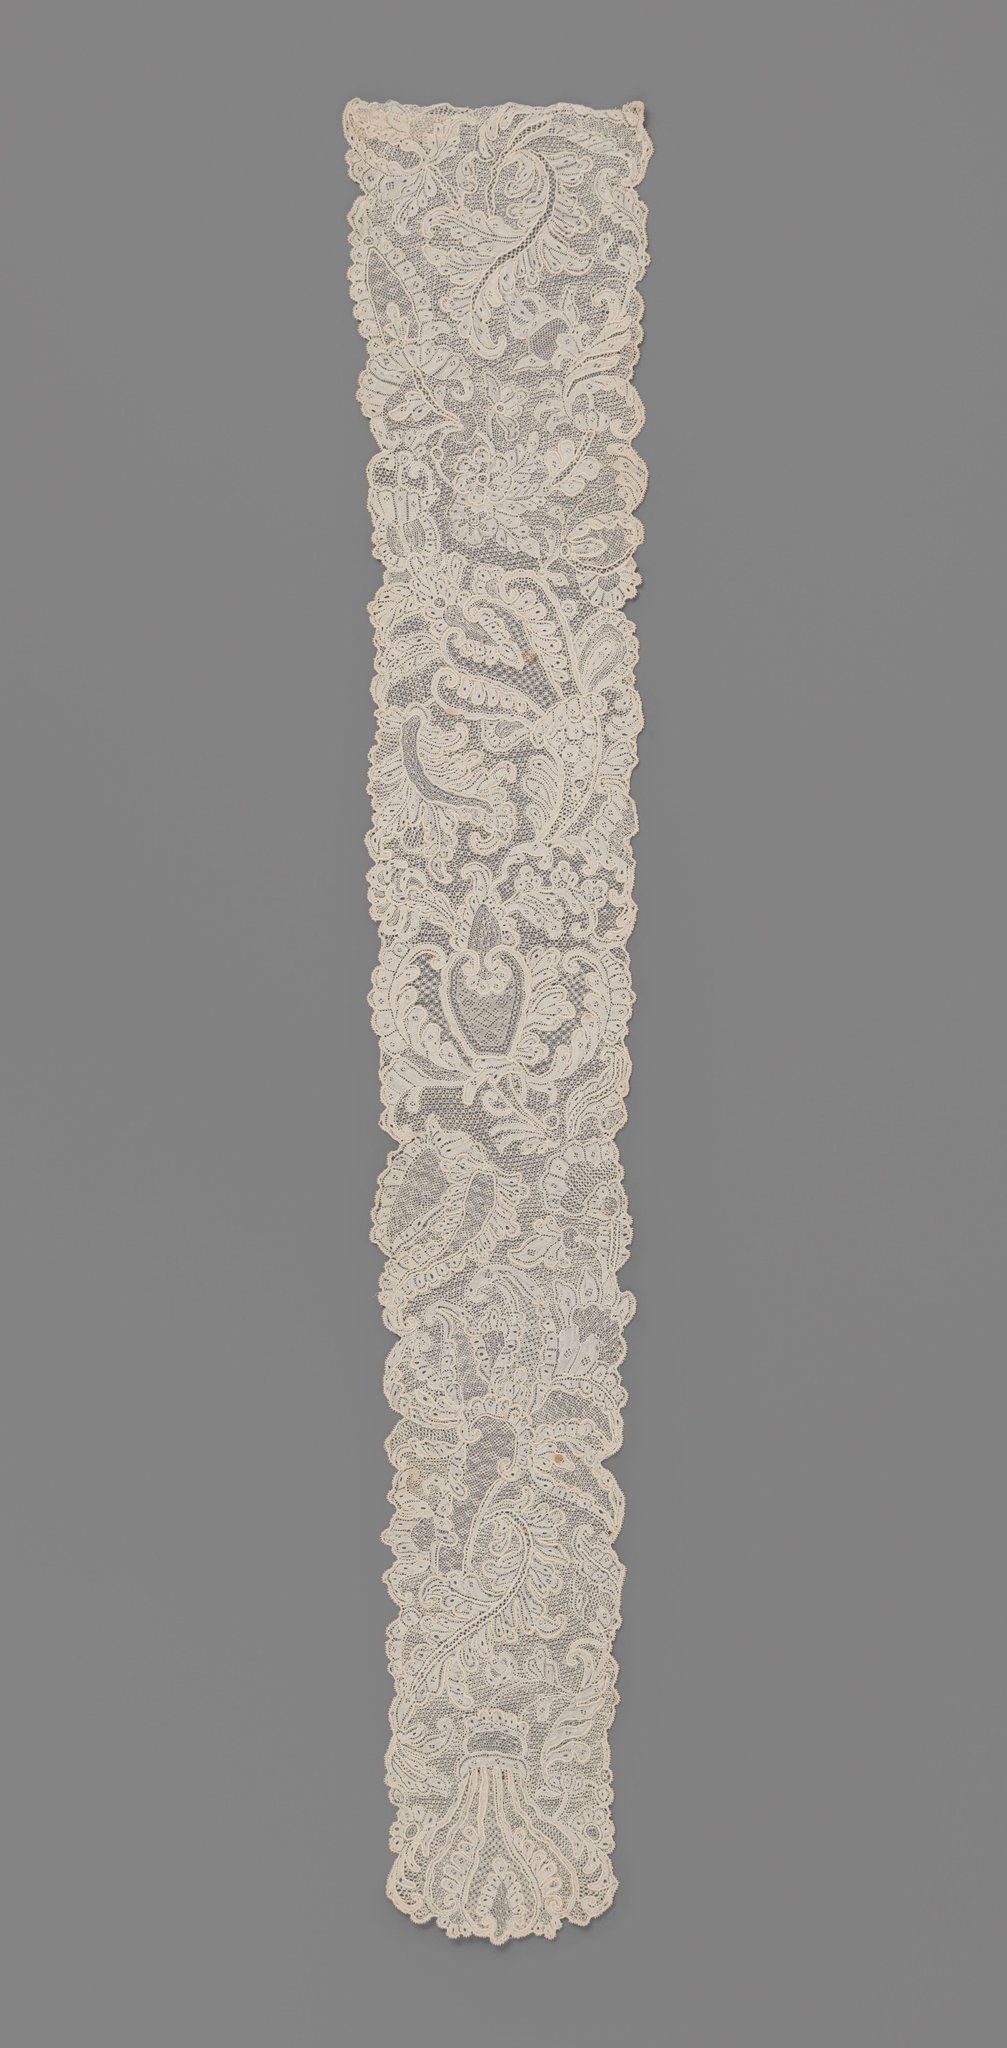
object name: womenswear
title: Mutsenslip van naaldkant met acanthusbladeren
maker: Anonymous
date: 1720-1730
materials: linen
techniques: needle lace, régence lace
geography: france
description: Mutsenslip van naturelkleurige naaldkant, Régence-kant. Patroon met acanthusbladeren en weelderige bloemen, op een maasgrond versierd met vierkante moesjes. Volwerk met uitsparingen en veelsoortige siersteken. Reliëfcontouren met festonsteken.